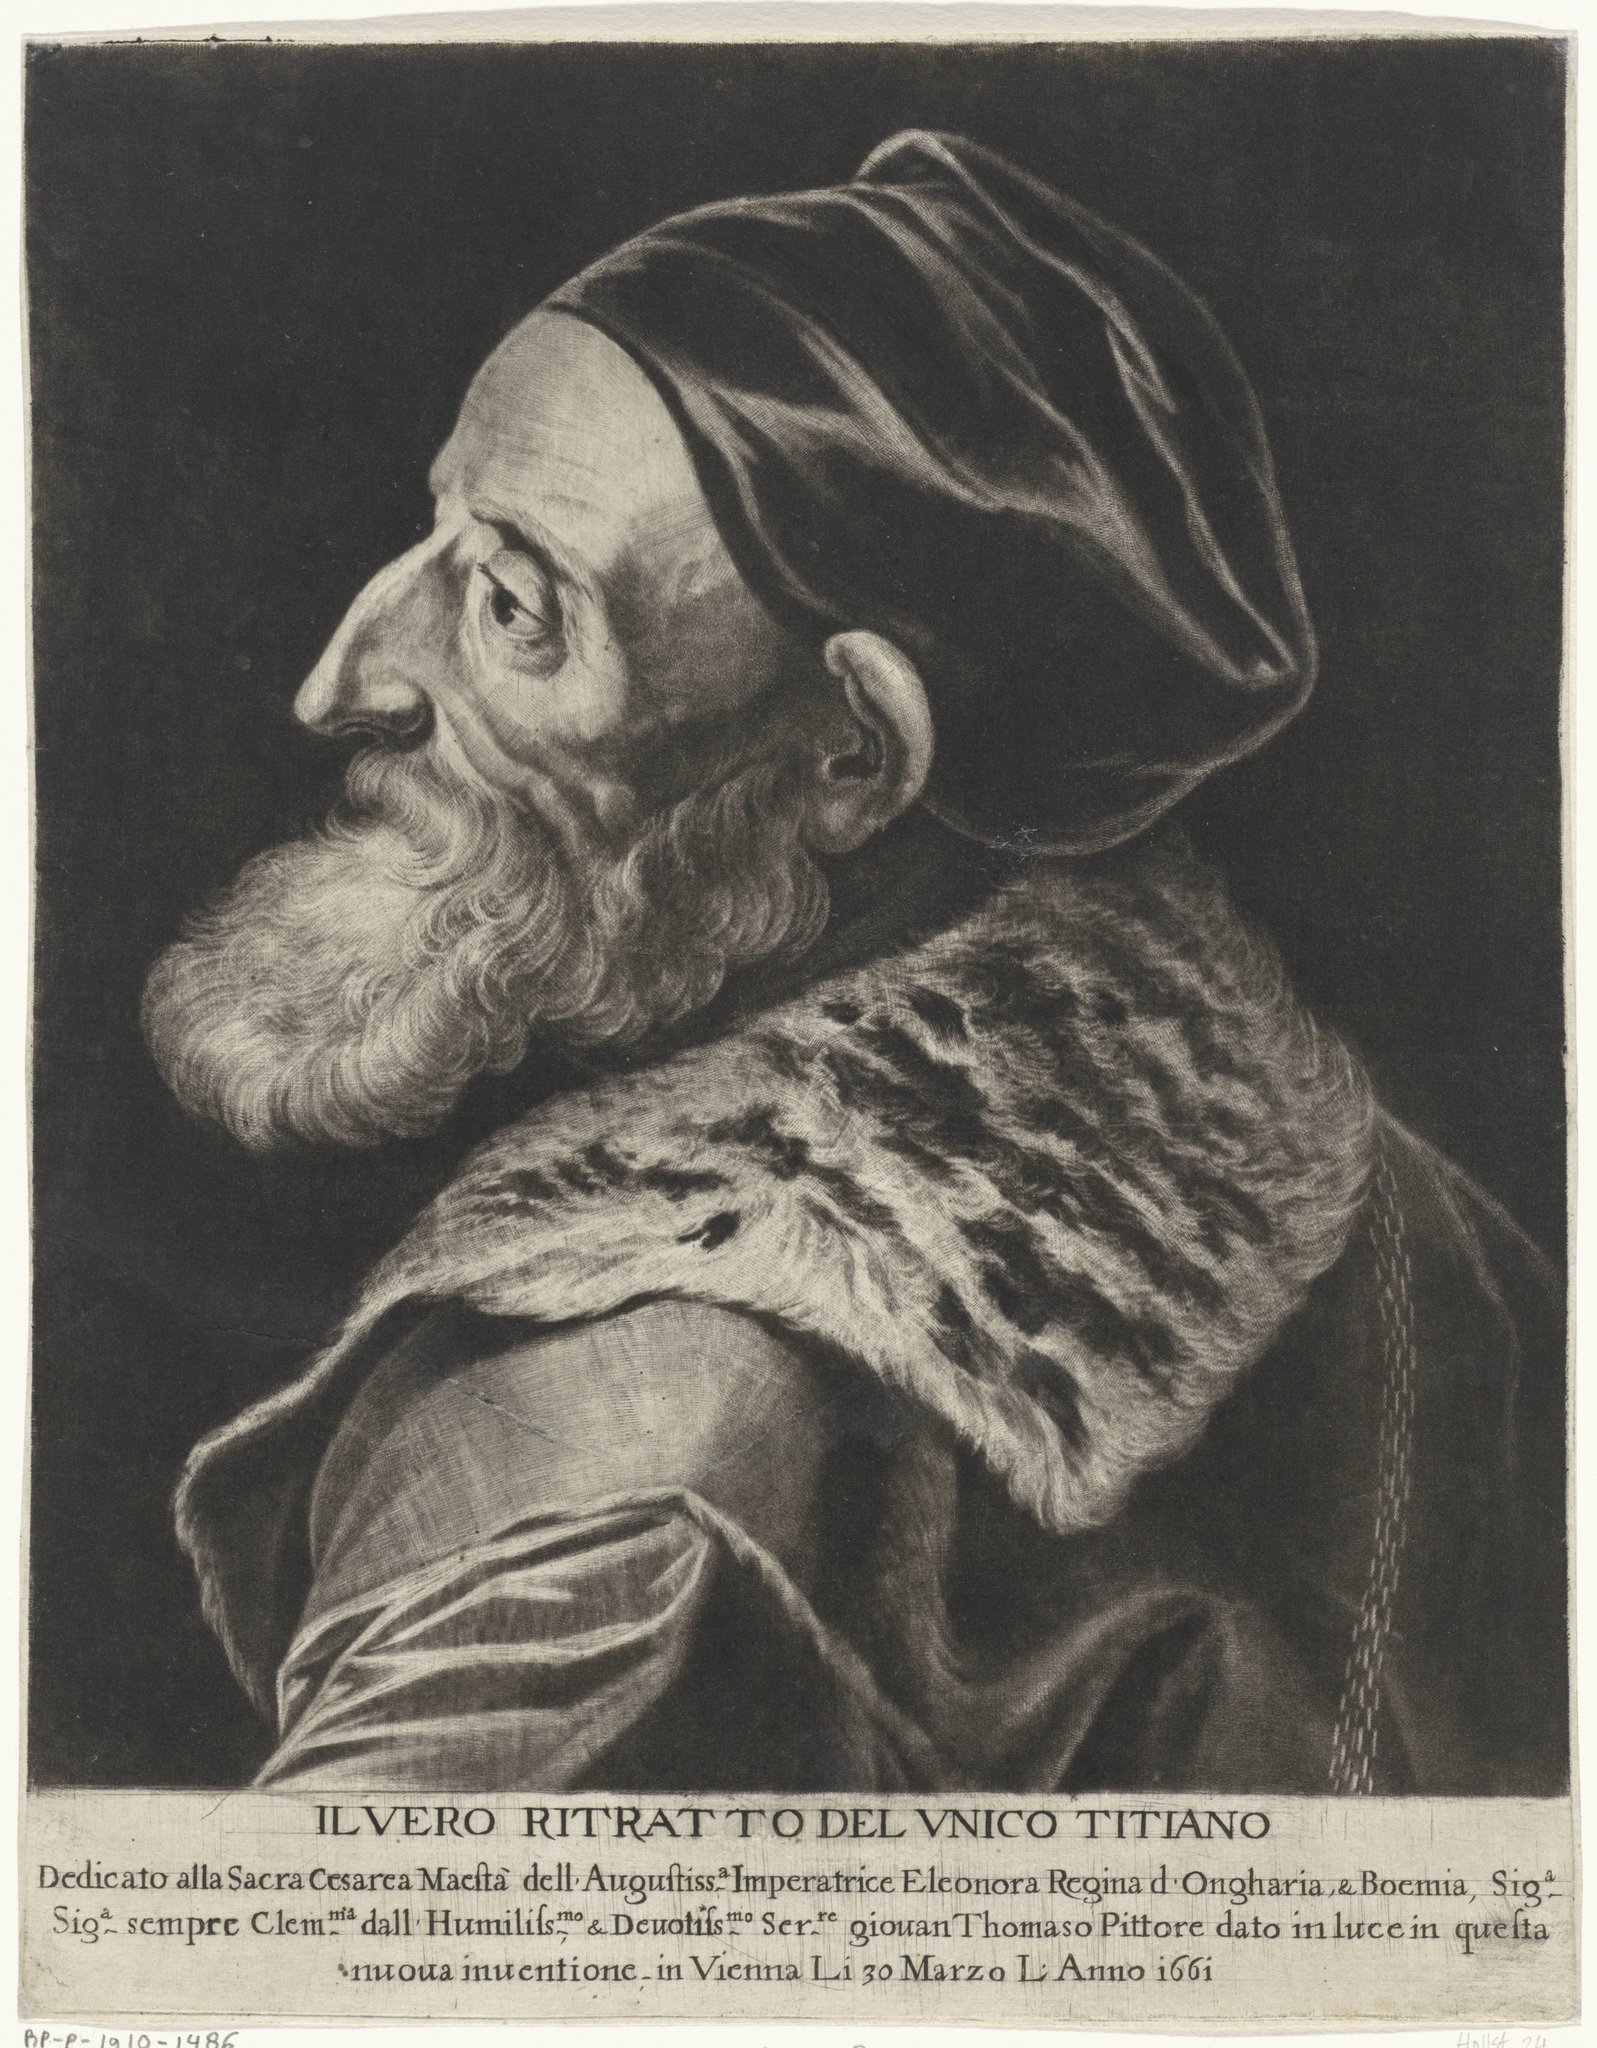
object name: print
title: Zelfportret van Titiaan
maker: jan thomas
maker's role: print maker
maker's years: 1617-1678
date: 1661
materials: paper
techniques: engraving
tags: venice, painter, draughtsman, titiaan, portrait, self-portrait of painter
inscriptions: collector's mark: Lugt 2228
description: De Italiaanse schilder Tiziano Vecelli in profiel.